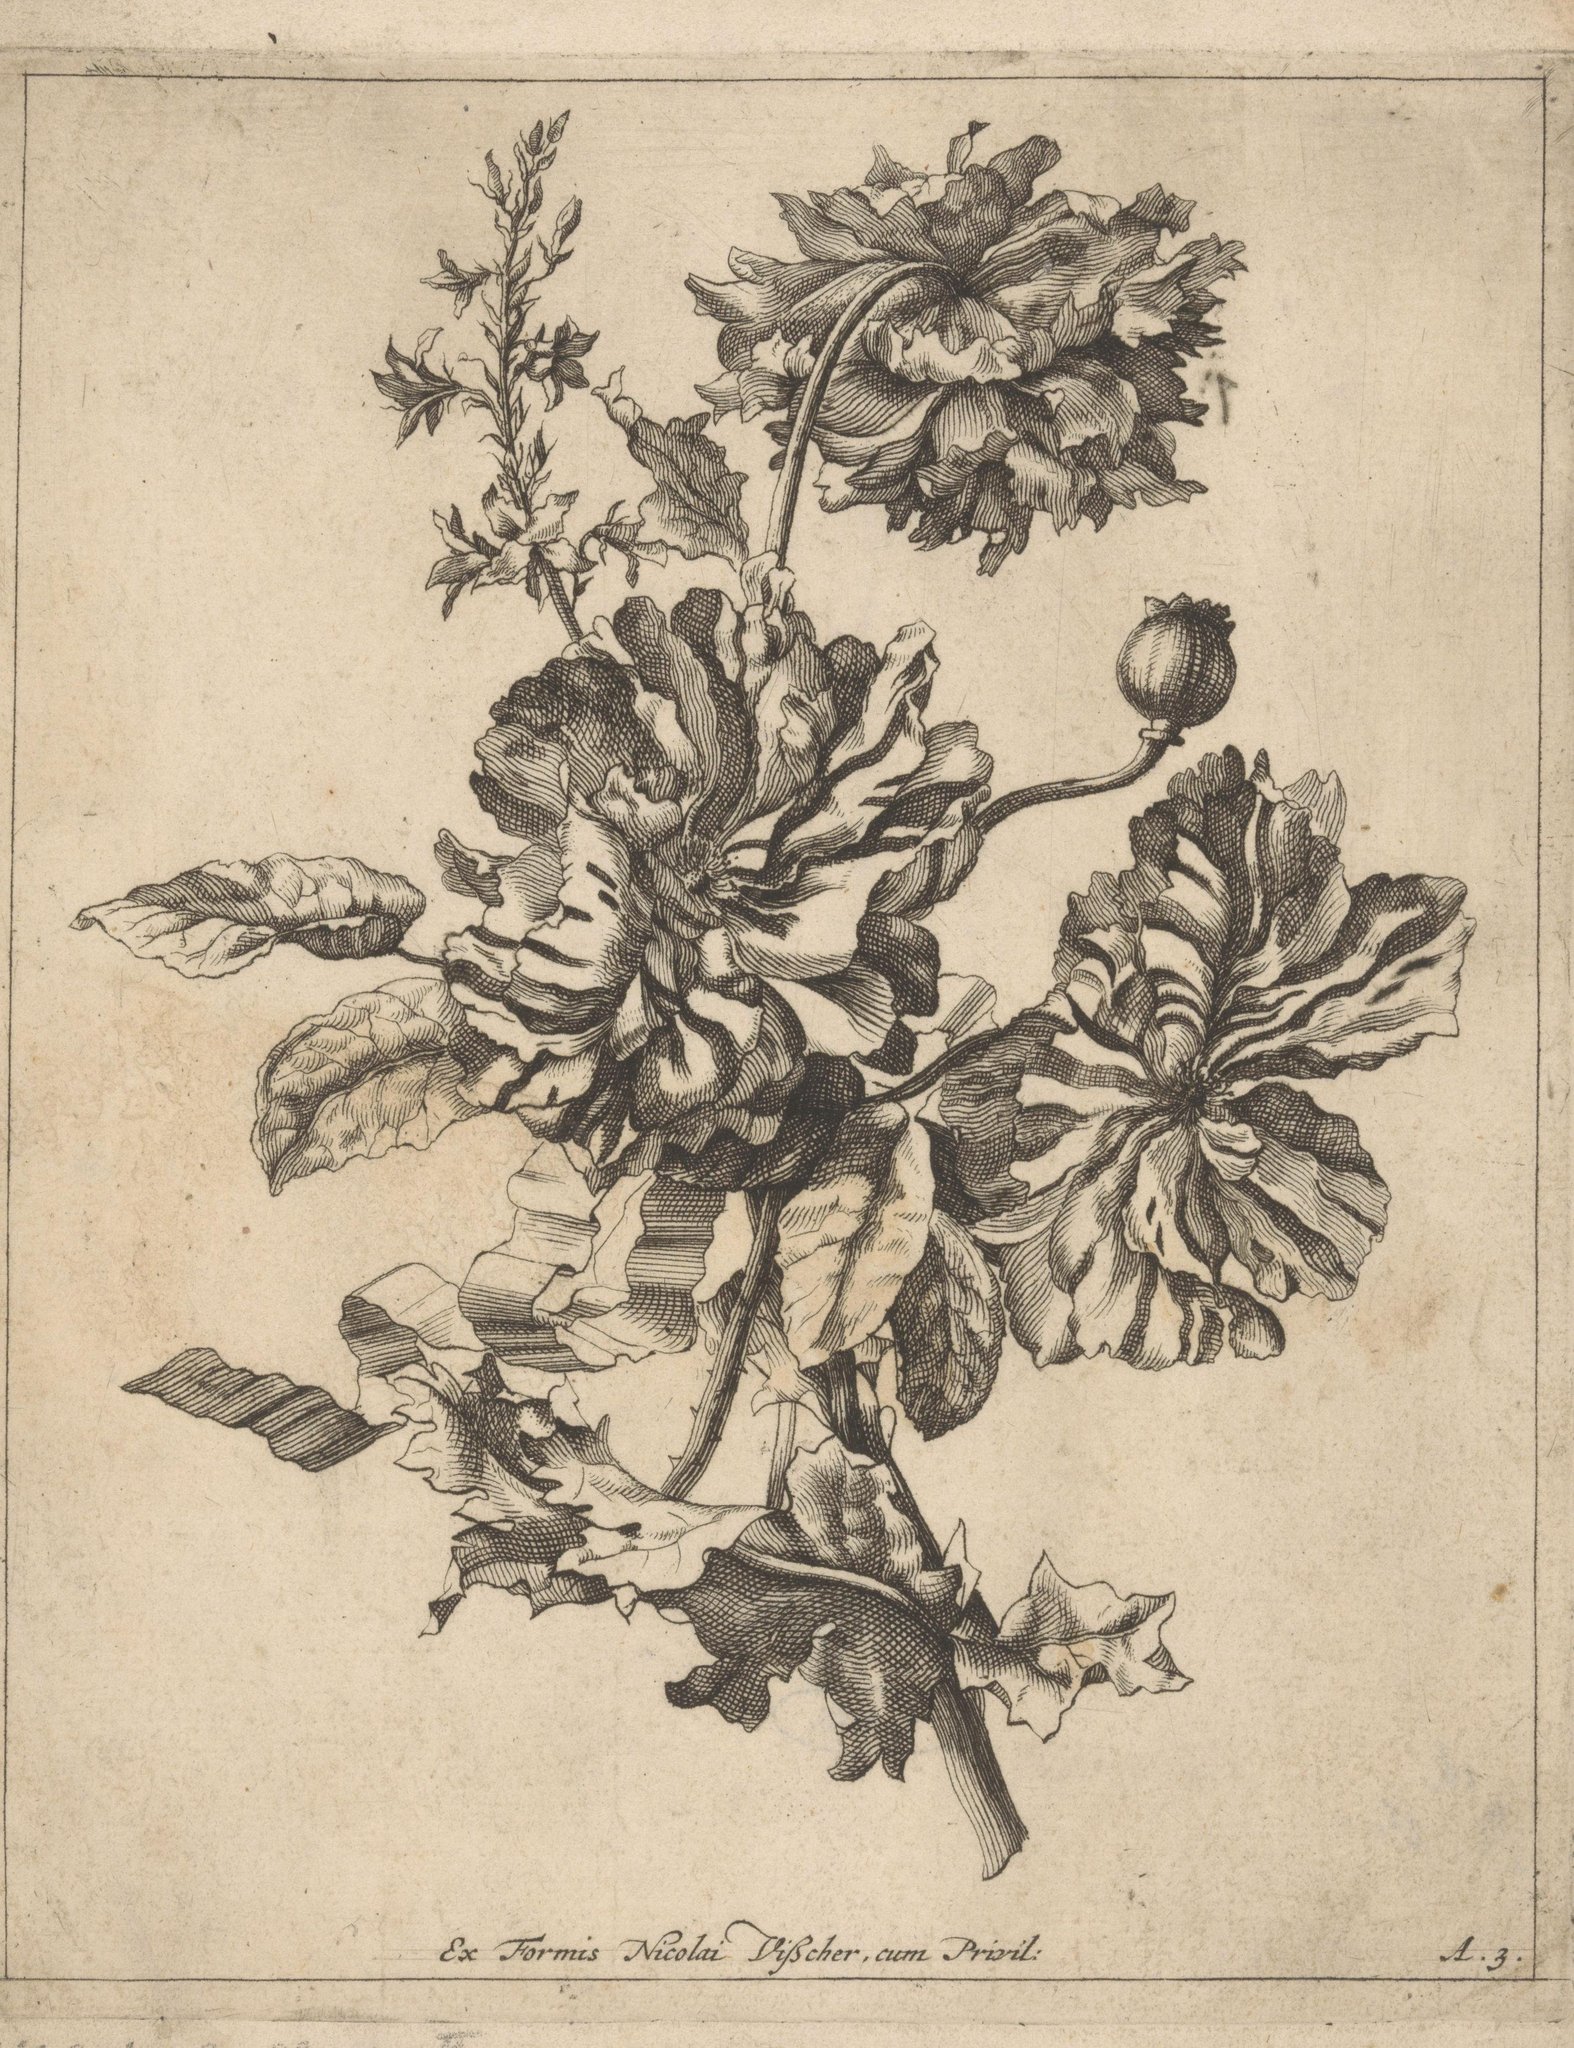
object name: print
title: Drie pioenrozen en papaverknop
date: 1679-1702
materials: paper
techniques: engraving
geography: amsterdam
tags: flowers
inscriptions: collector's mark: Lugt 2228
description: Studie van pioenroosachtige bloemen. Rechts onder A.3. genummerd.